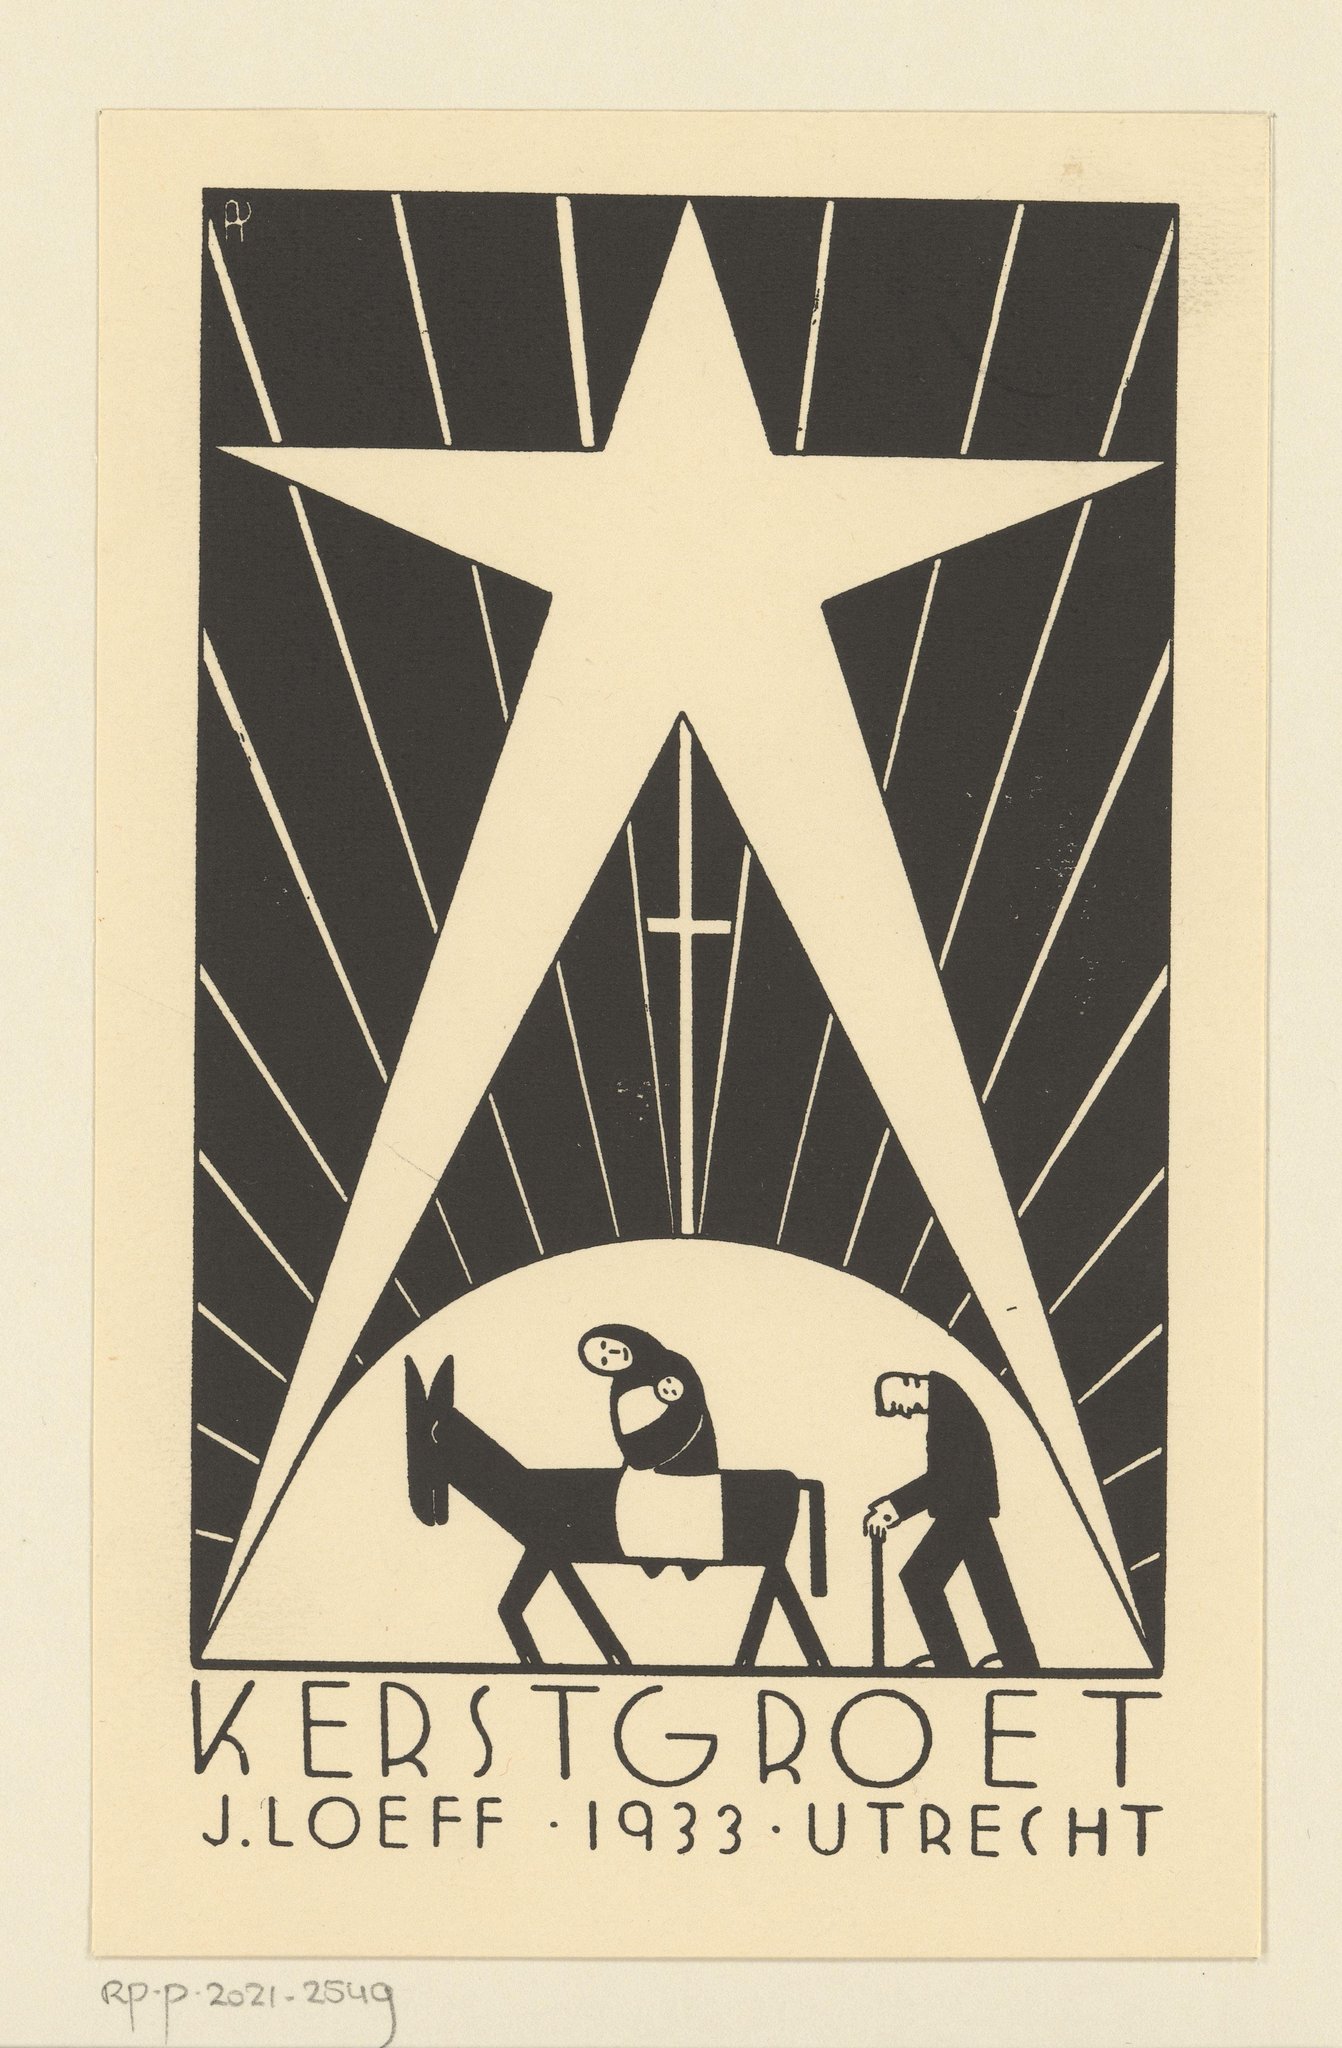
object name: christmas card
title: Kerstkaart voor 1933 van J. Loeff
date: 1933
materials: paper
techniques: printing block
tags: holy family, and derived representations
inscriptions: date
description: Voor de rechtenbepaling van dit object is bij gebrek aan data van vervaardigers gebruik gemaakt van de vervaardigingsdatum van het object.